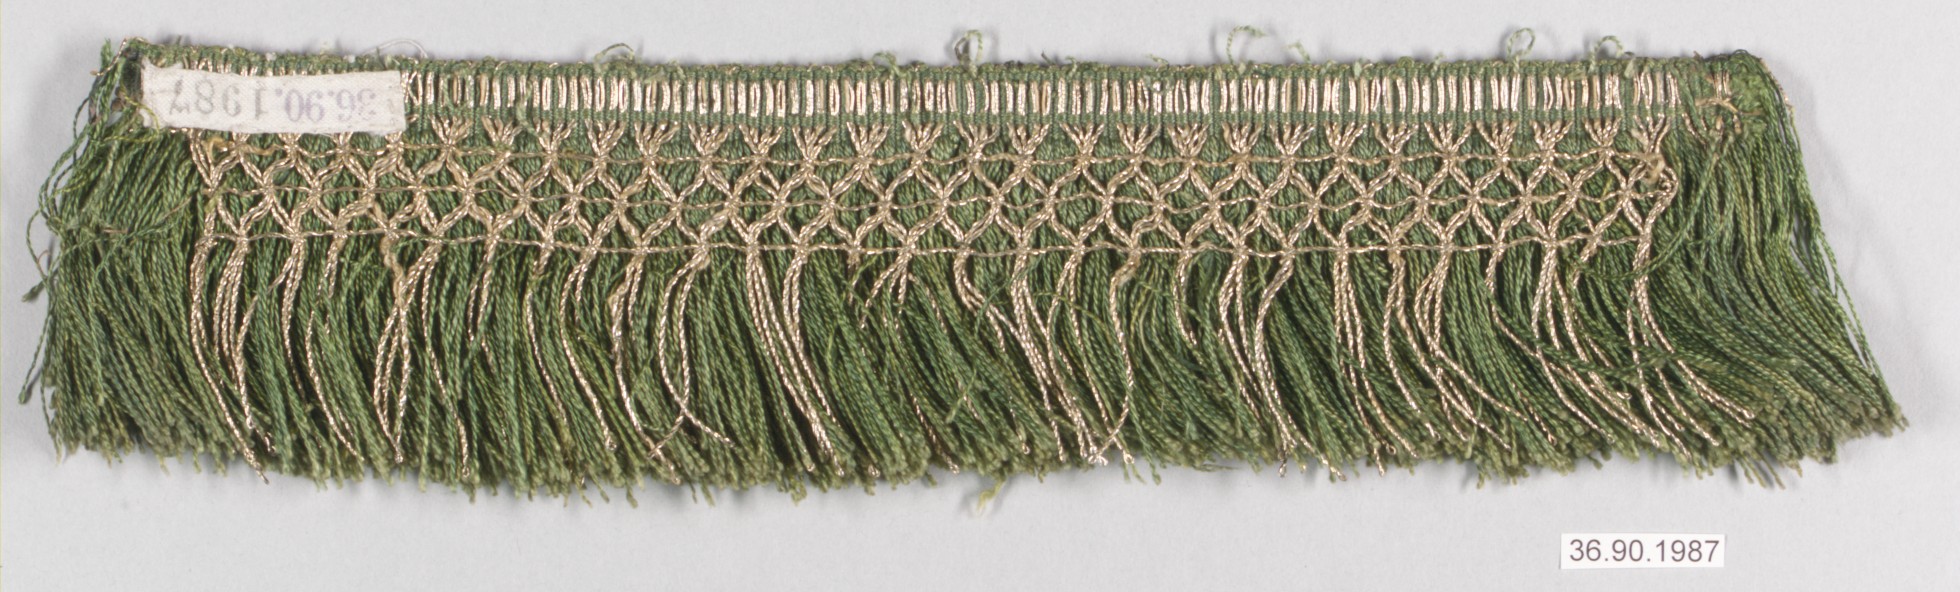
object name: fringe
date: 1750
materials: metal thread, silk